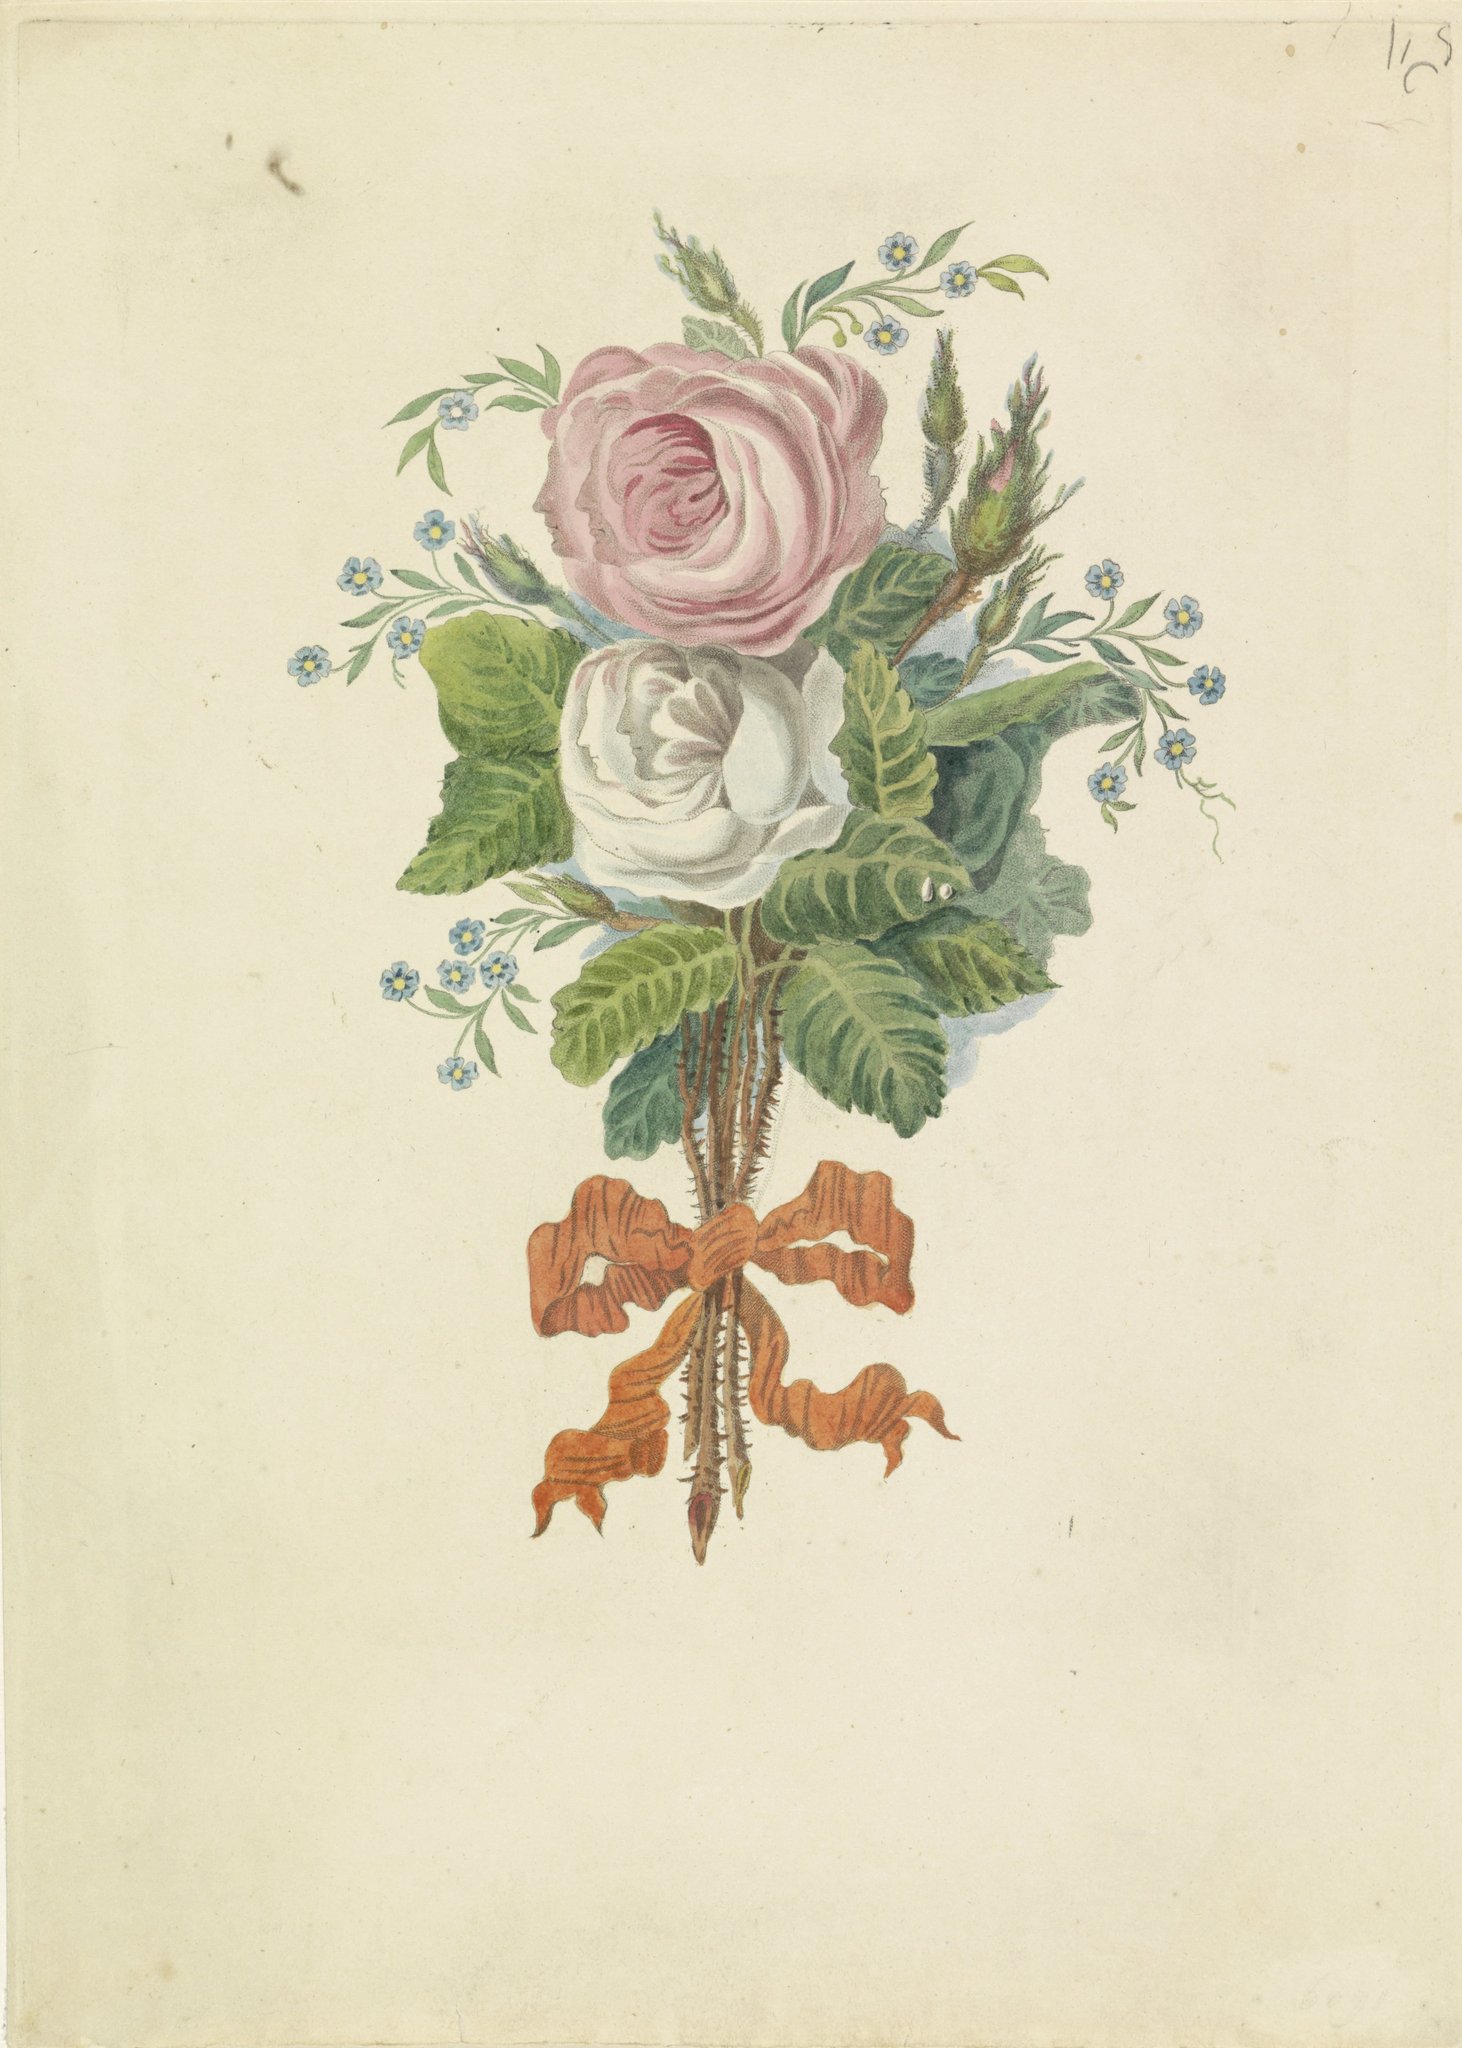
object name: print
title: Rozen met de silhouetten van de Koninklijke familie, 1816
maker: leonardus schweickhardt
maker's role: print maker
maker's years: 1783-1862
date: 1816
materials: paper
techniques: engraving, etching, hand coloring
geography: amsterdam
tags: the hague, anna paulowna romanowa, berlin, william i of the netherlands, william ii of the netherlands, painter, draughtsman, wilhelmina of prussia (princess of orange), louise (prinses van oranje-nassau), frederik (prins der nederlanden), voorburg, marianne (prinses der nederlanden), wilhelmina frederica louisa (koningin der nederlanden), flowers: rose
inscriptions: collector's mark: Lugt 2228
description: Boeket met een roze en een witte roos waarin de silhouetten van de Koninklijke familie zijn verwerkt. De rozen met een oranjelint bijeen gebonden. Naar aanleiding van het huwelijk van de prins van Oranje en Anna Paulowna te Sint Petersburg op 21 februari 1816. Onder de bloemen een achtregelig vers en lijst van de namen van de geportretteerden.